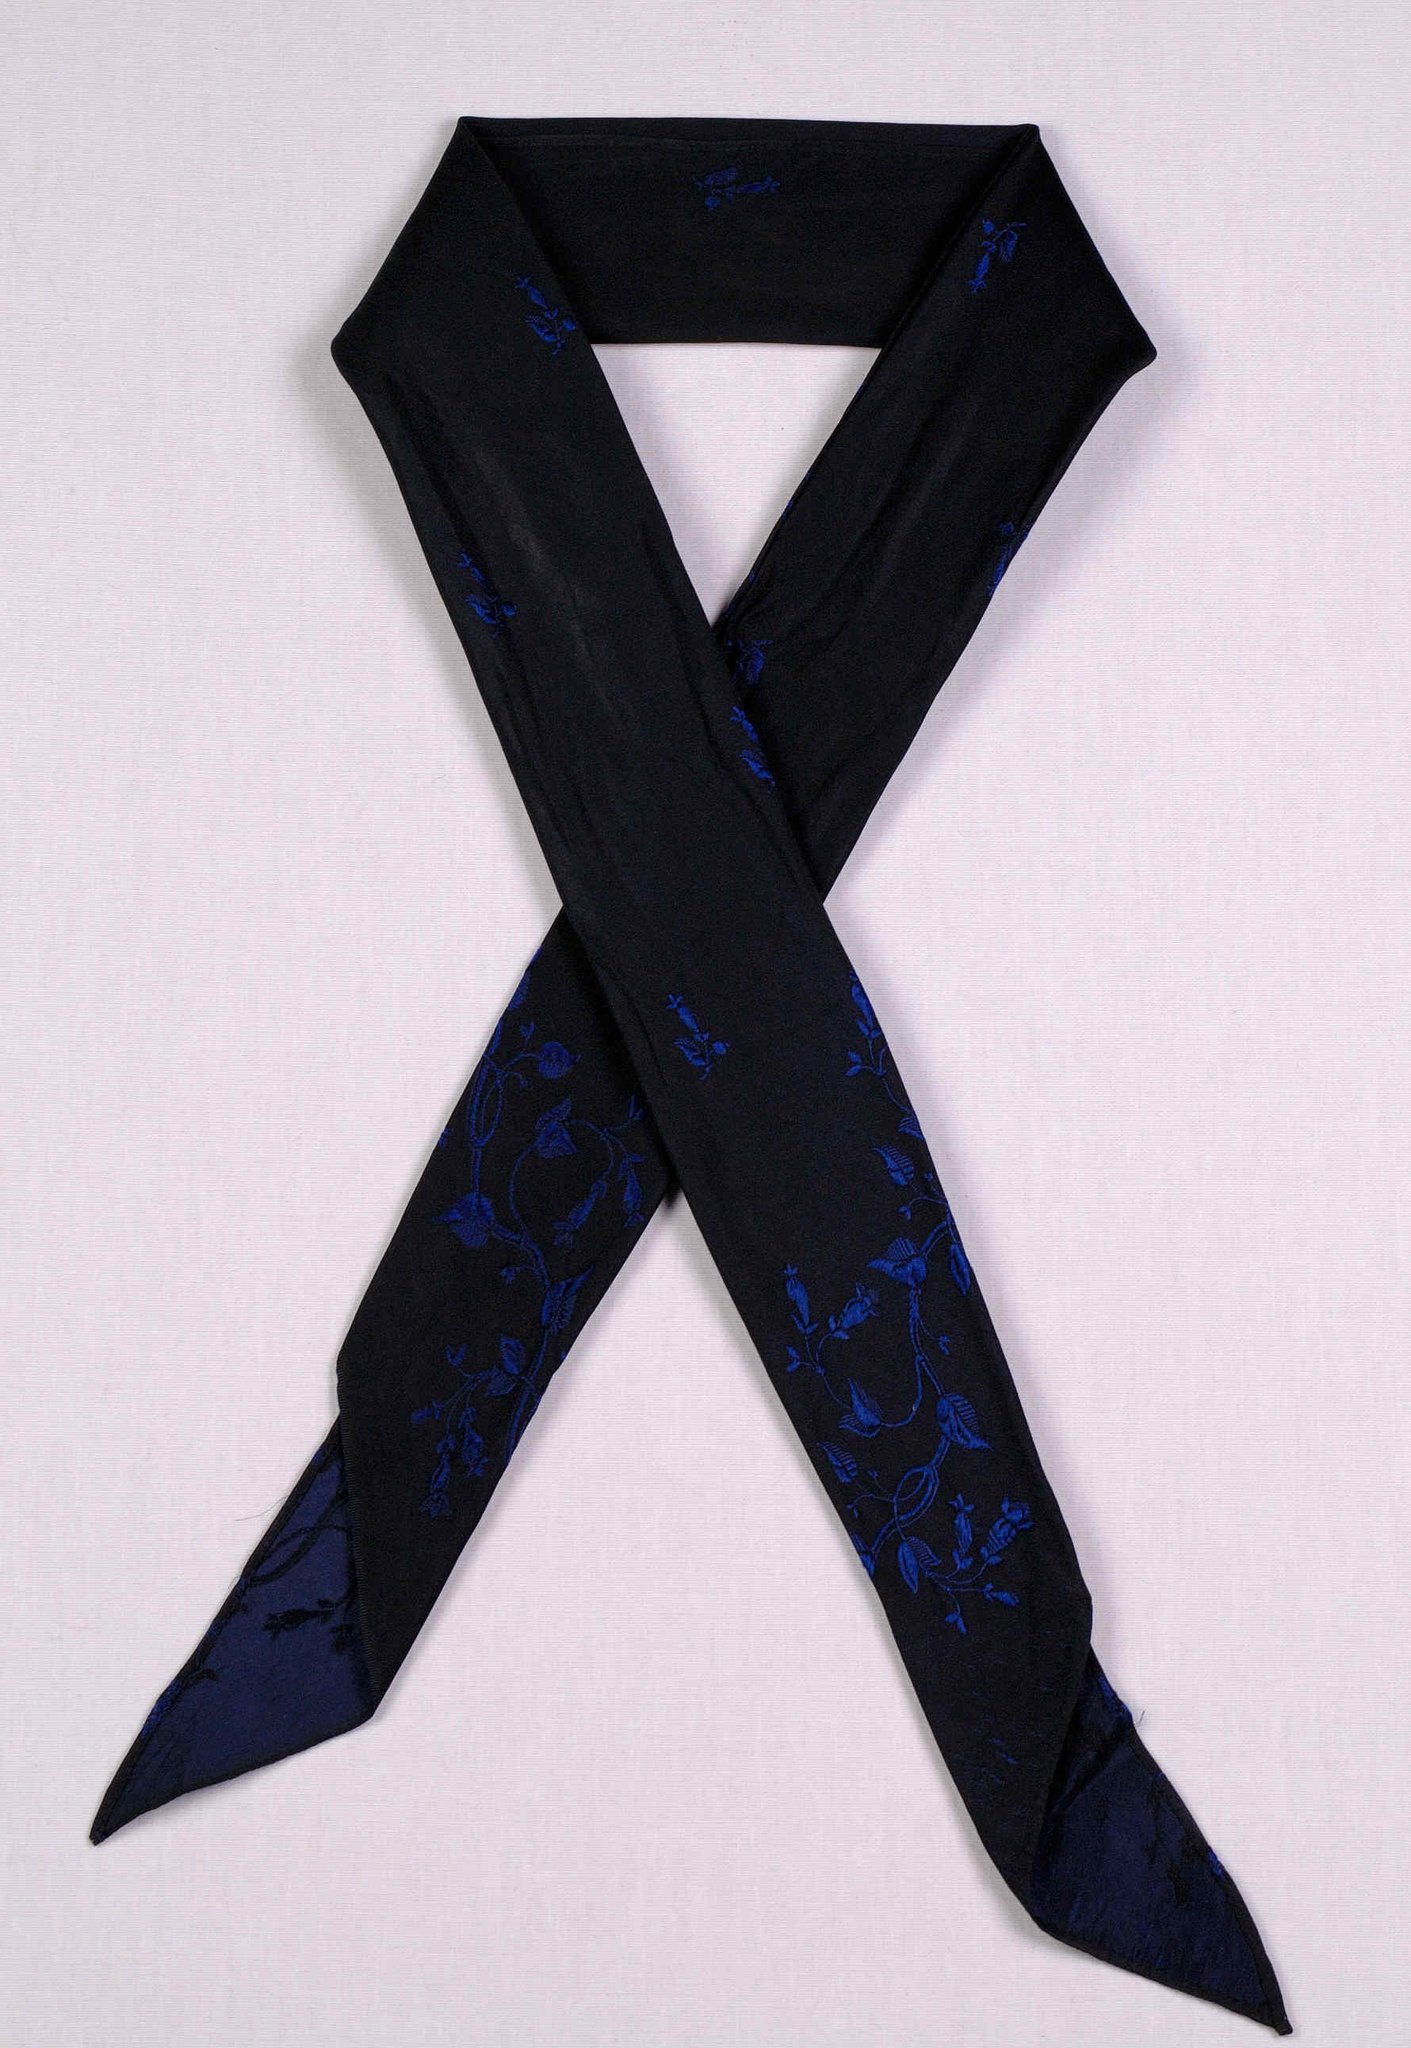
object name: cravat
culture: american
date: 1850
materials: silk